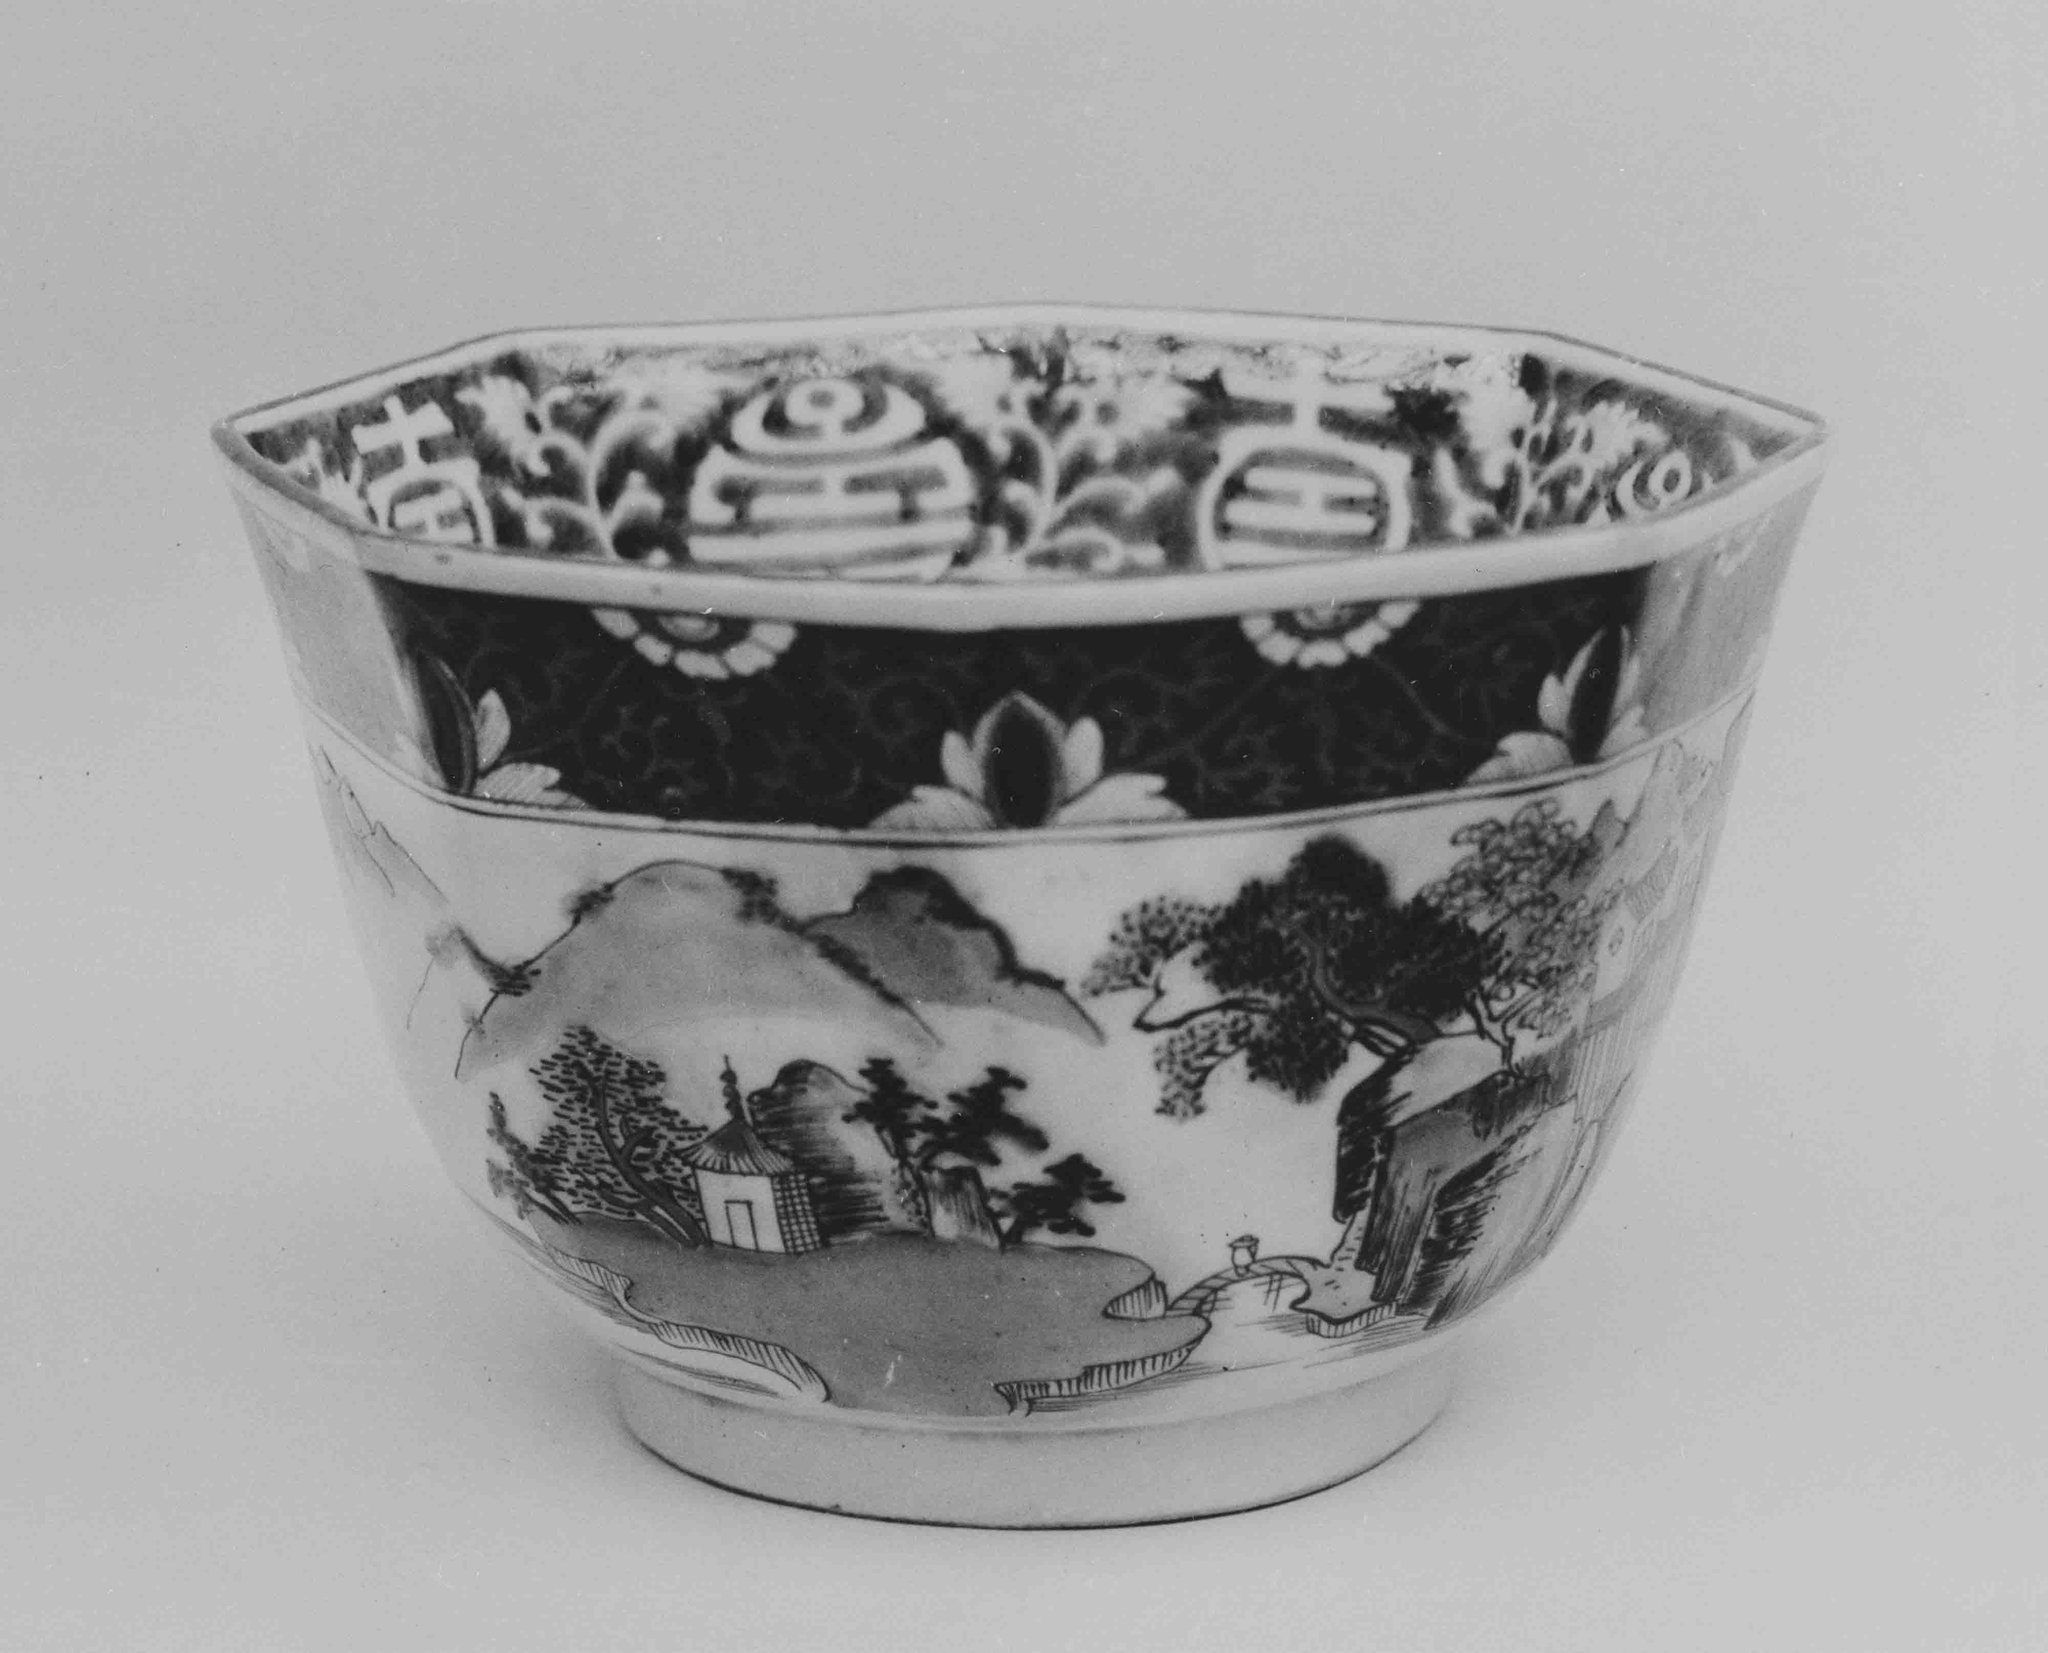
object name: bowl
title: Octagonal Bowl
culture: japanese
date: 1820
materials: enamel, porcelain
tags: mountains,landscapes